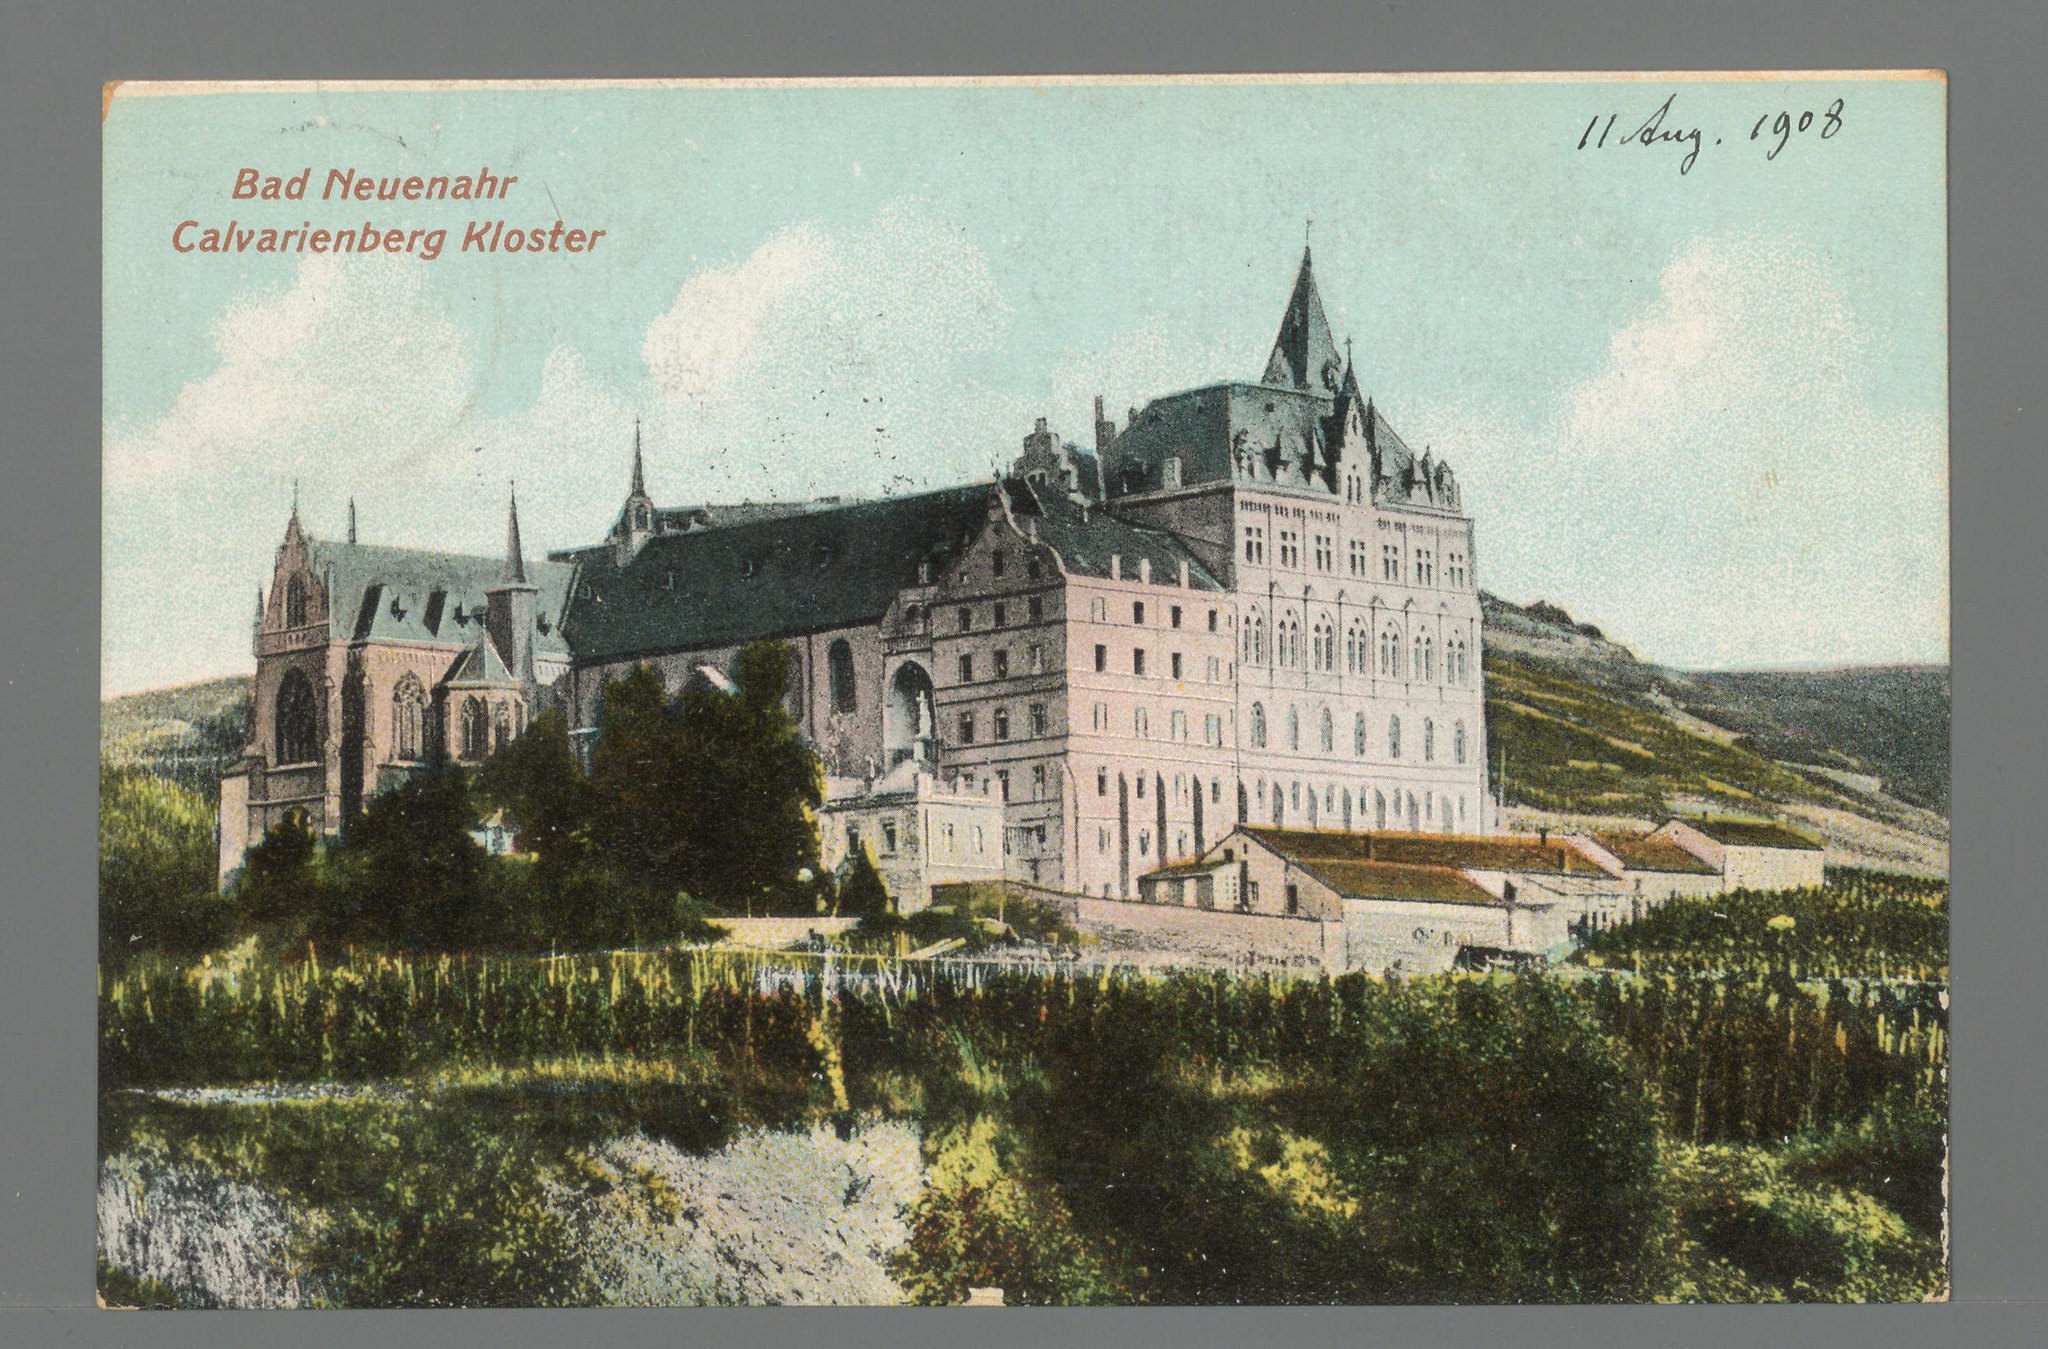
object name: ansichtkaart, prentbriefkaart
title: Bad Neuenahr. Calvarienberg Kloster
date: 1905-1908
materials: cardboard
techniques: lithograph, writing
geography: bad neuenahr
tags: abbey, monastery, convent ~ roman catholic church, mountains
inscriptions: postage stamp